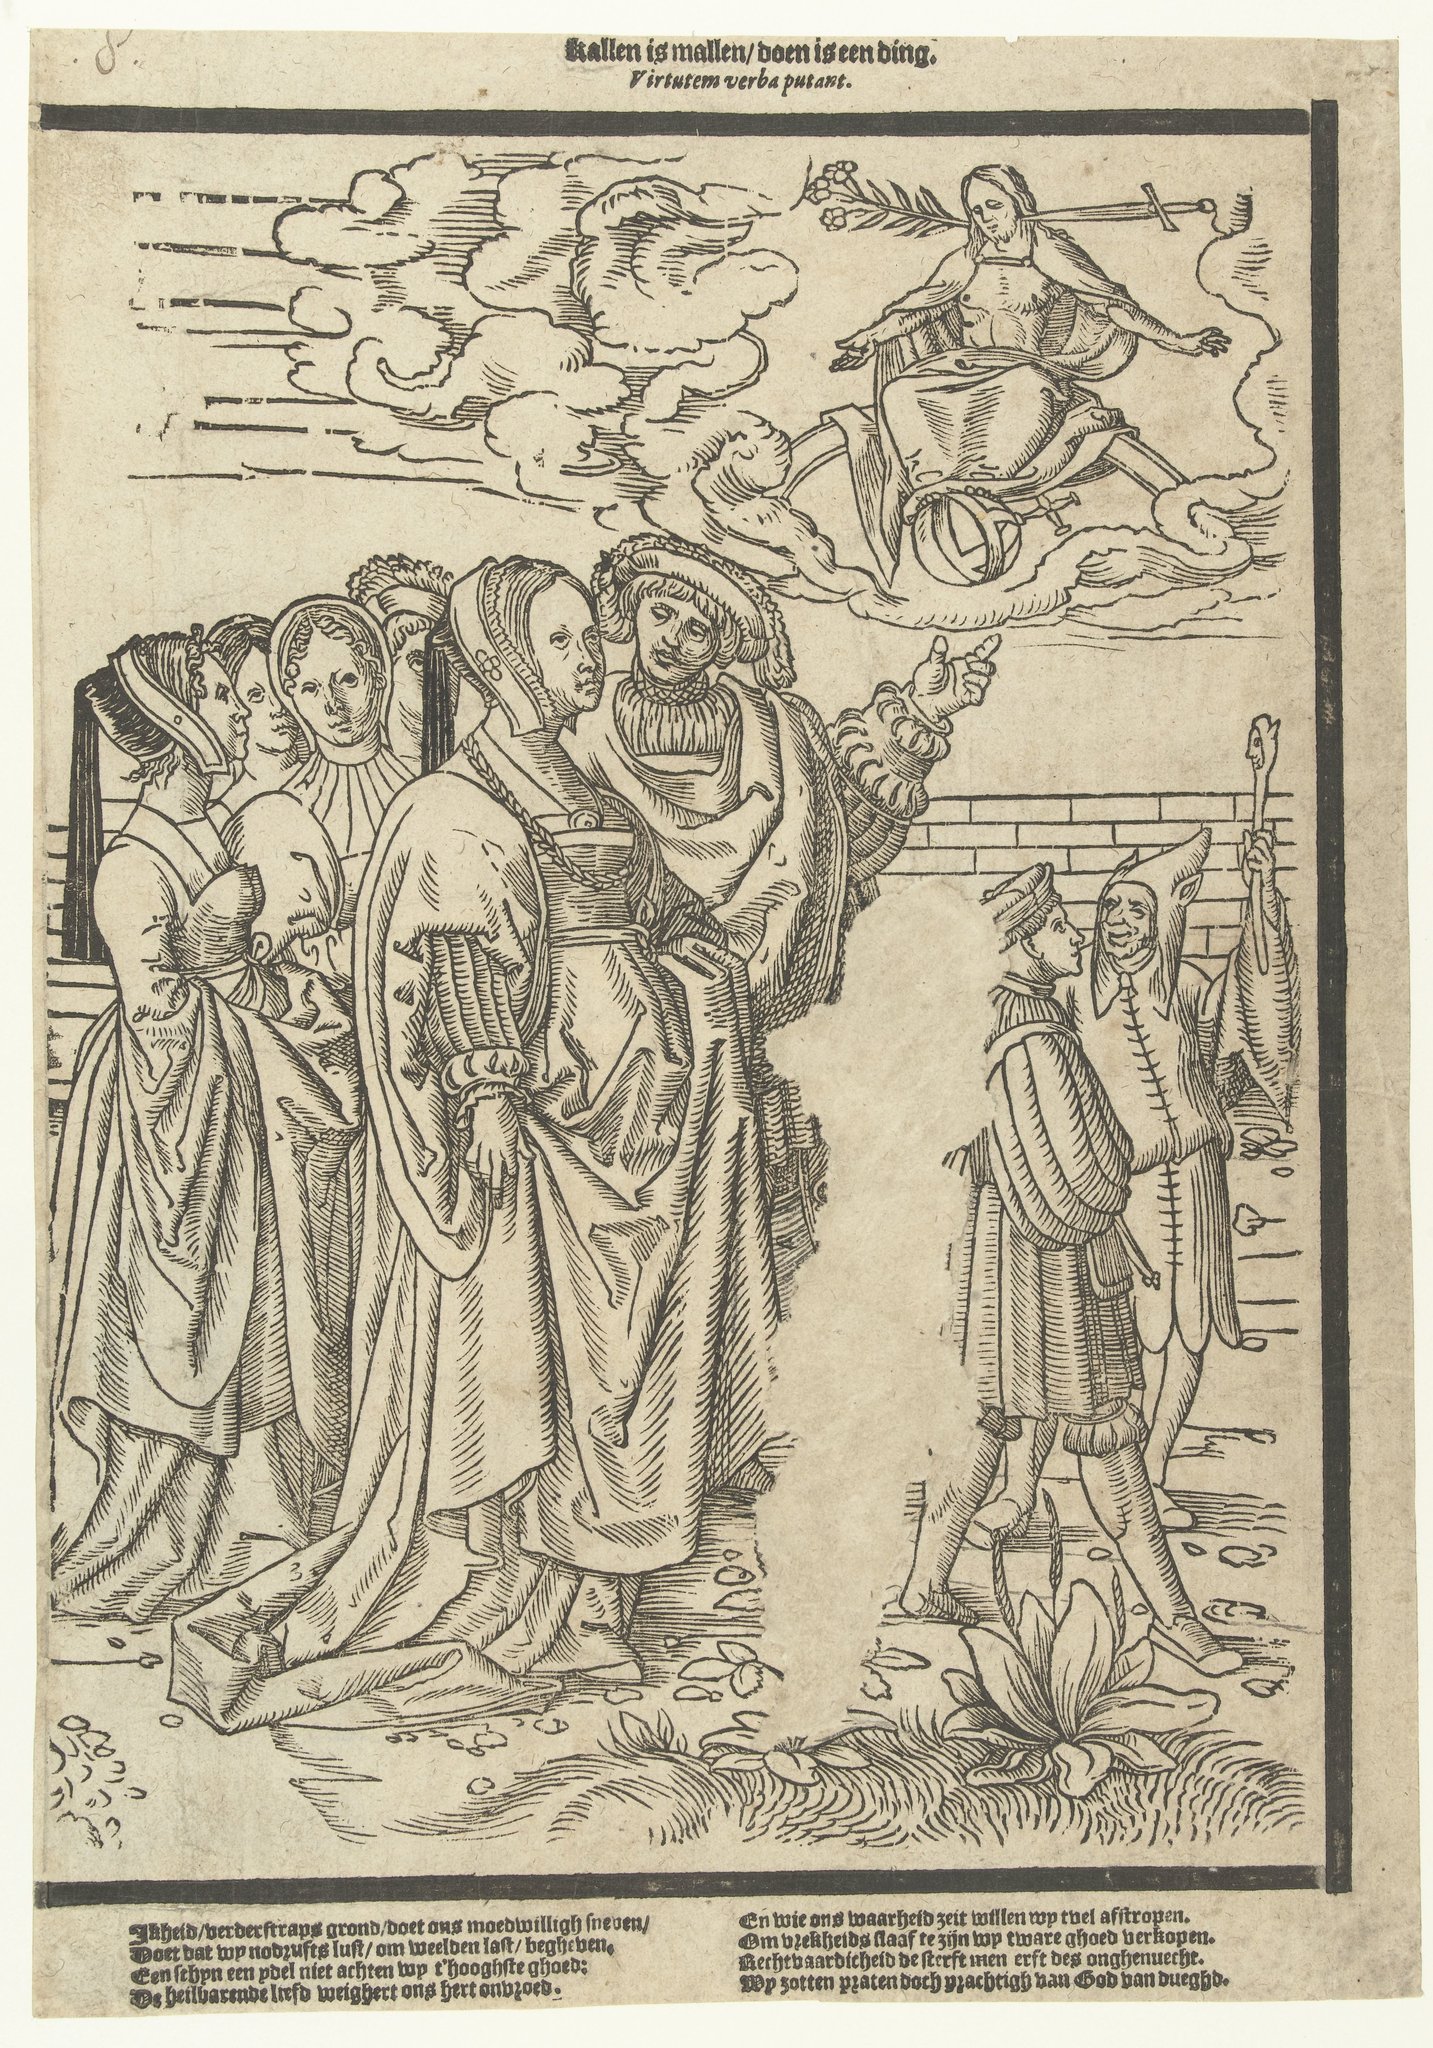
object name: print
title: Verderf-traps beeld-schrift ofte heiligh letteren dat is. Hieroglifica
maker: Anonymous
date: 1520-1560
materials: paper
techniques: woodcut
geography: low countries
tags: proverbs, sayings, etc.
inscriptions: collector's mark: Lugt 2228a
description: Eén van acht moraliserende spreuken verbeeld: Rijke jongeman wijst jonge vrouw op Christus, zittend in de hemel op regenboog met zwaard en lelie. Andere man volgt een nar. Tekst onder prent.